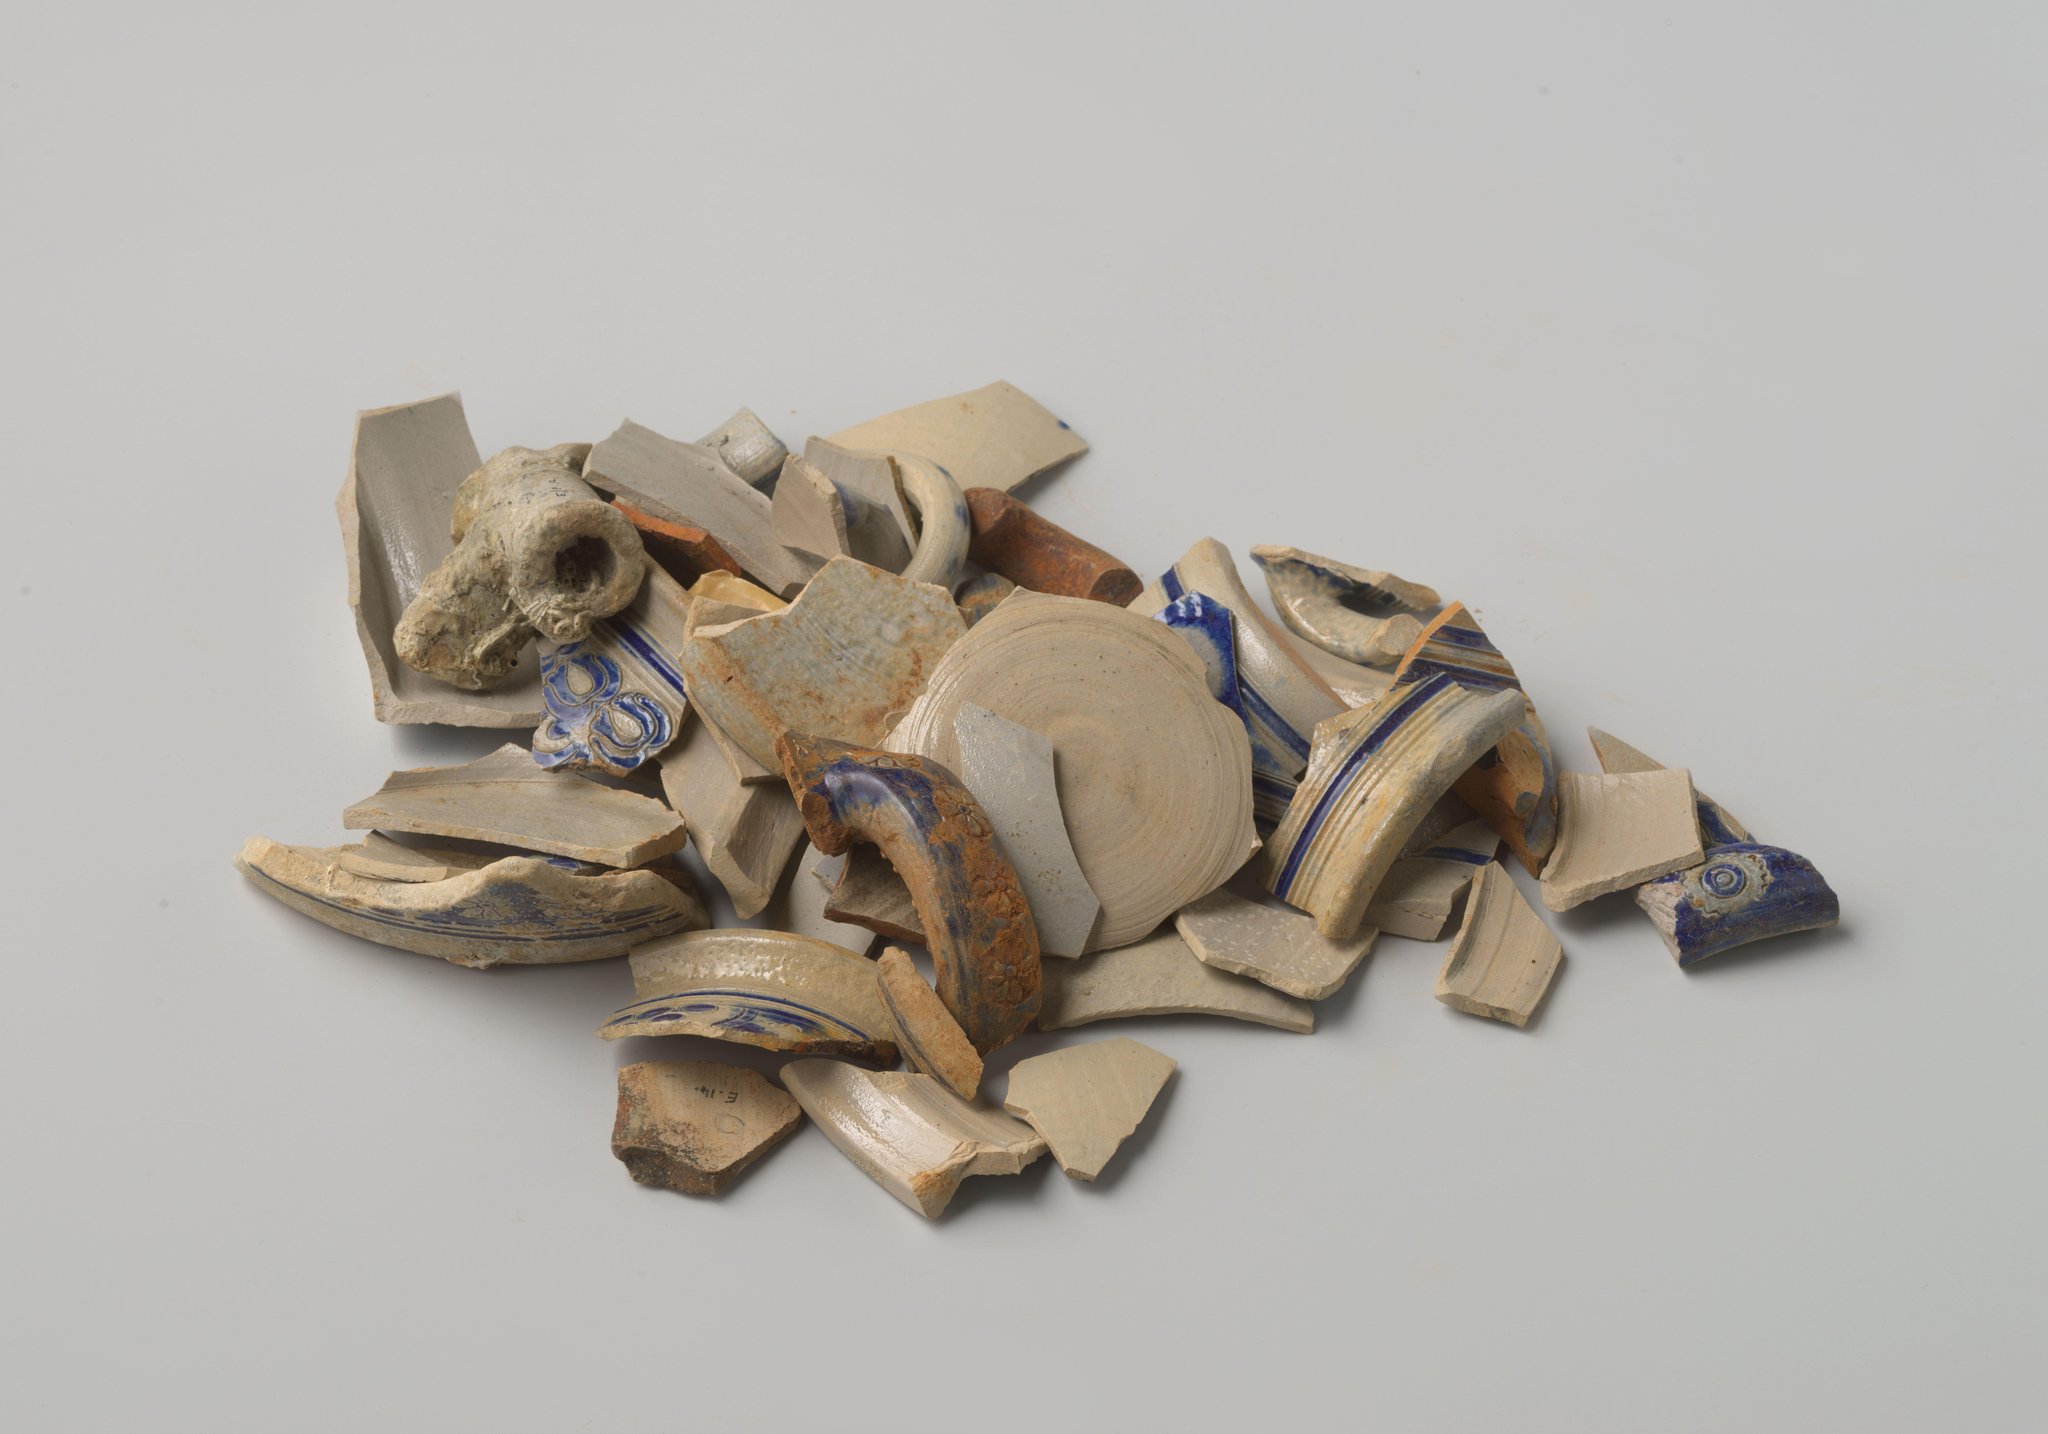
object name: sherd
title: Scherven steengoed uit het wrak van de Oost-Indiëvaarder Hollandia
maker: Anonymous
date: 1700-1743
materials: glaze, stoneware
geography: westerwald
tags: verenigde oostindische compagnie, hollandia (schip), annet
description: Scherven steengoed met grijs en blauw glazuur.